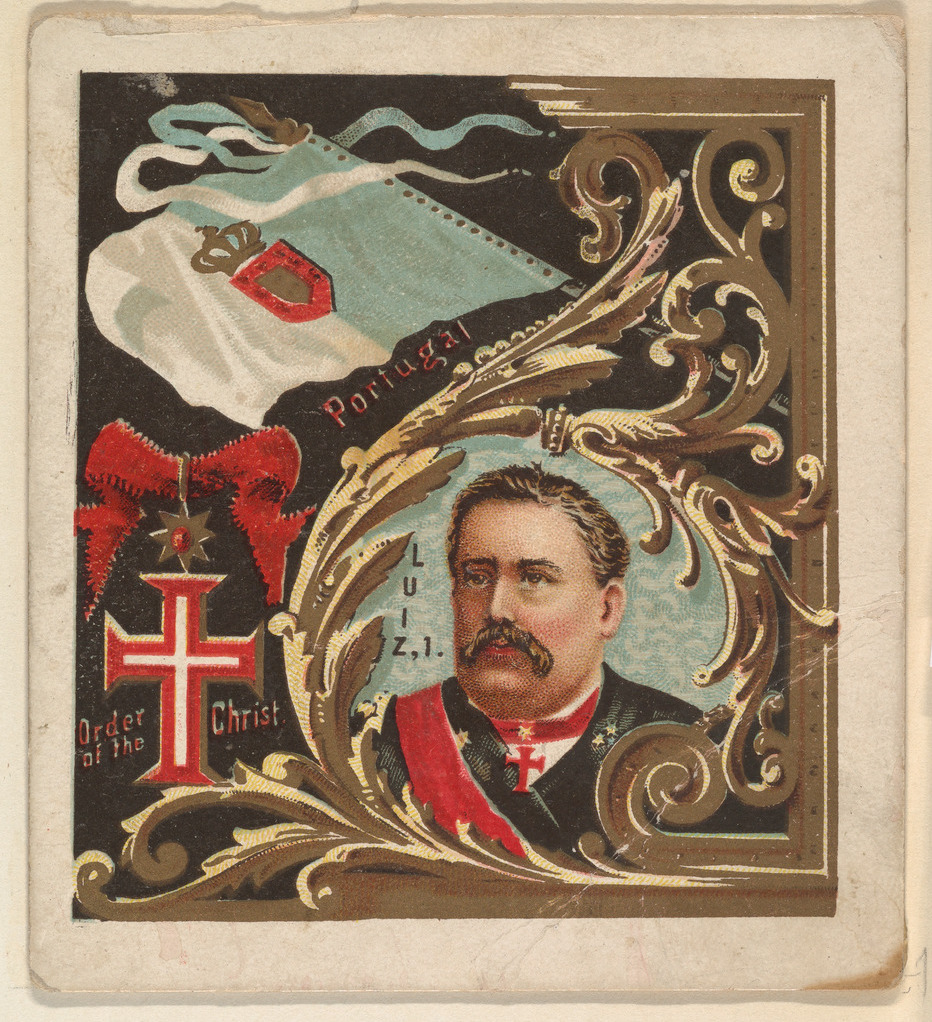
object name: print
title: Portugal, from the International Cards series (N238), issued by Kinney Bros.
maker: kinney brothers tobacco company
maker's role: publisher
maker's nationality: american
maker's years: 1869-2011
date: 1888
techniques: color lithograph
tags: men,cross,coat of arms,flags